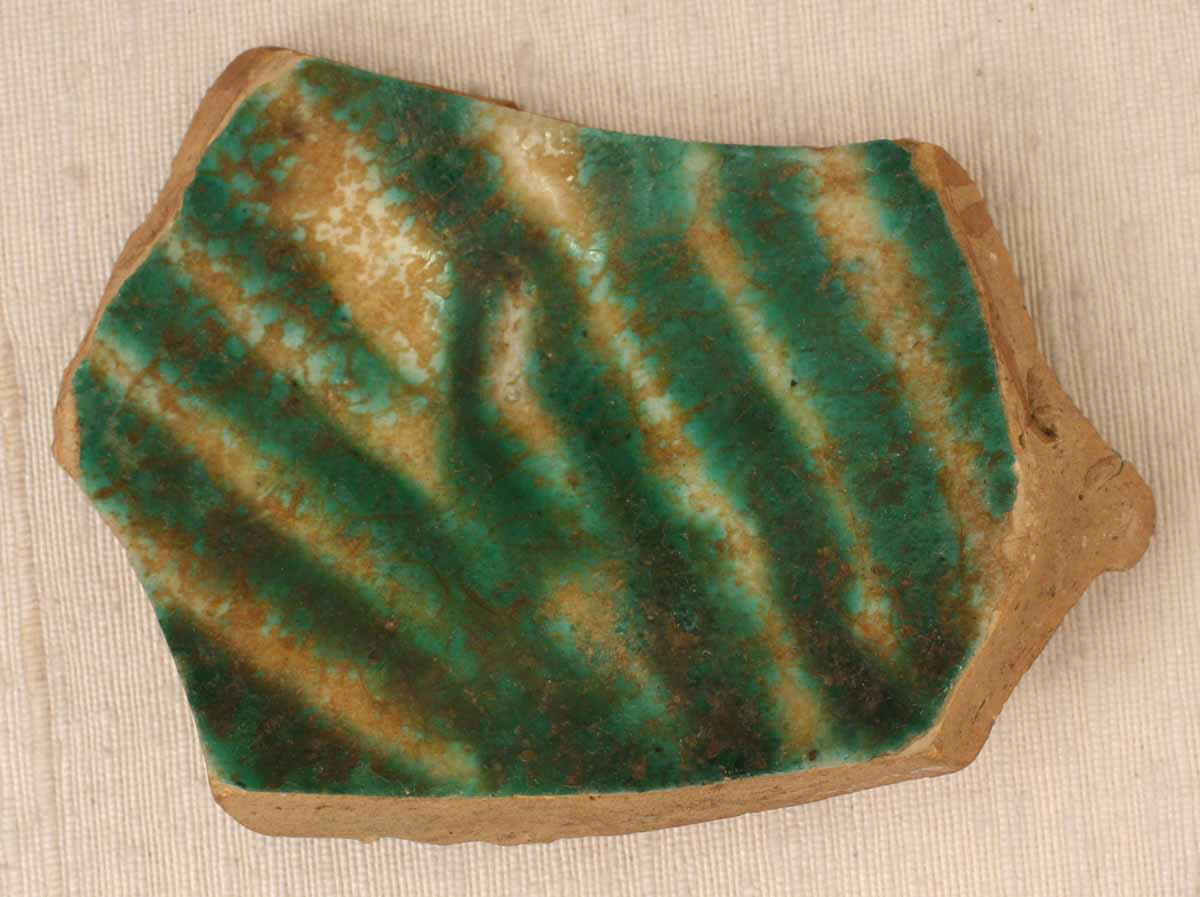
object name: fragment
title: Ceramic Fragment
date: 701-900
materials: earthenware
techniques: glazing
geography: iraq